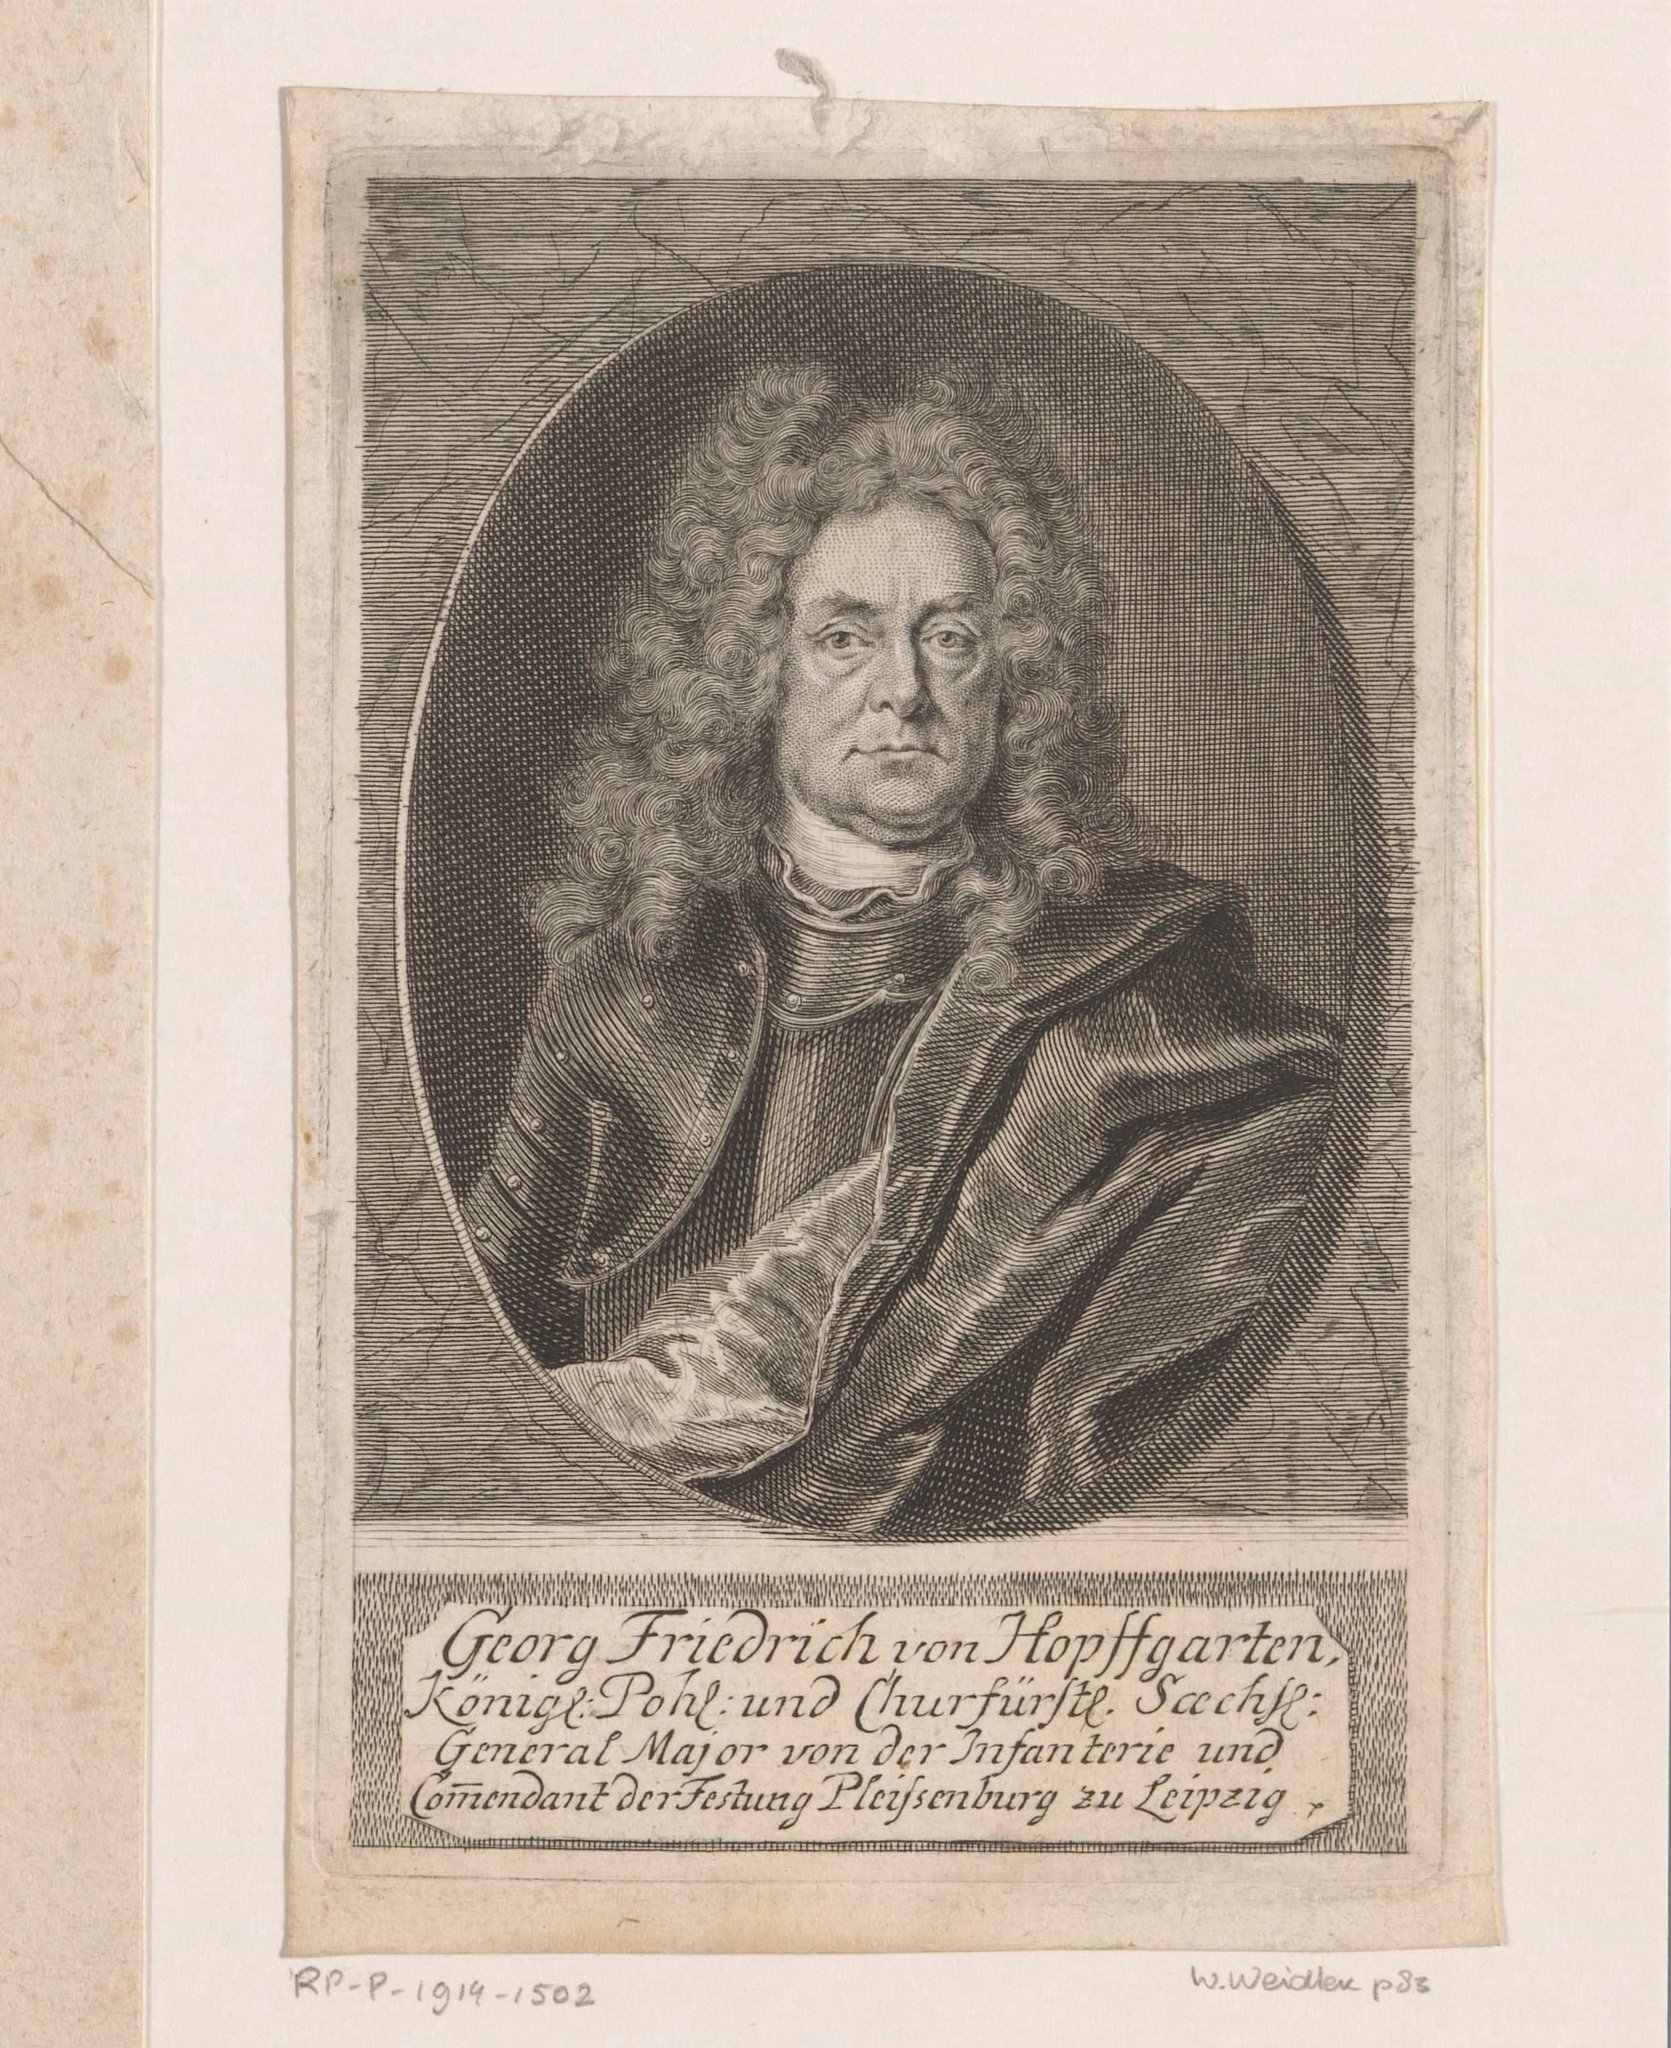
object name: print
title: Portret van Georg Friedrich von Hopffgarten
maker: martin bernigeroth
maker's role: print maker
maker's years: 1670-1733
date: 1725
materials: paper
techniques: engraving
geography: leipzig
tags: armour, historical persons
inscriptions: collector's mark: Lugt 2228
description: Prent ook gebruikt in: Die Europäische Fama, Welche den gegenwärtigen Zustand der vornehmsten Höfe entdecket. dl. 279. Leipzig: Gleditsch, 1725.